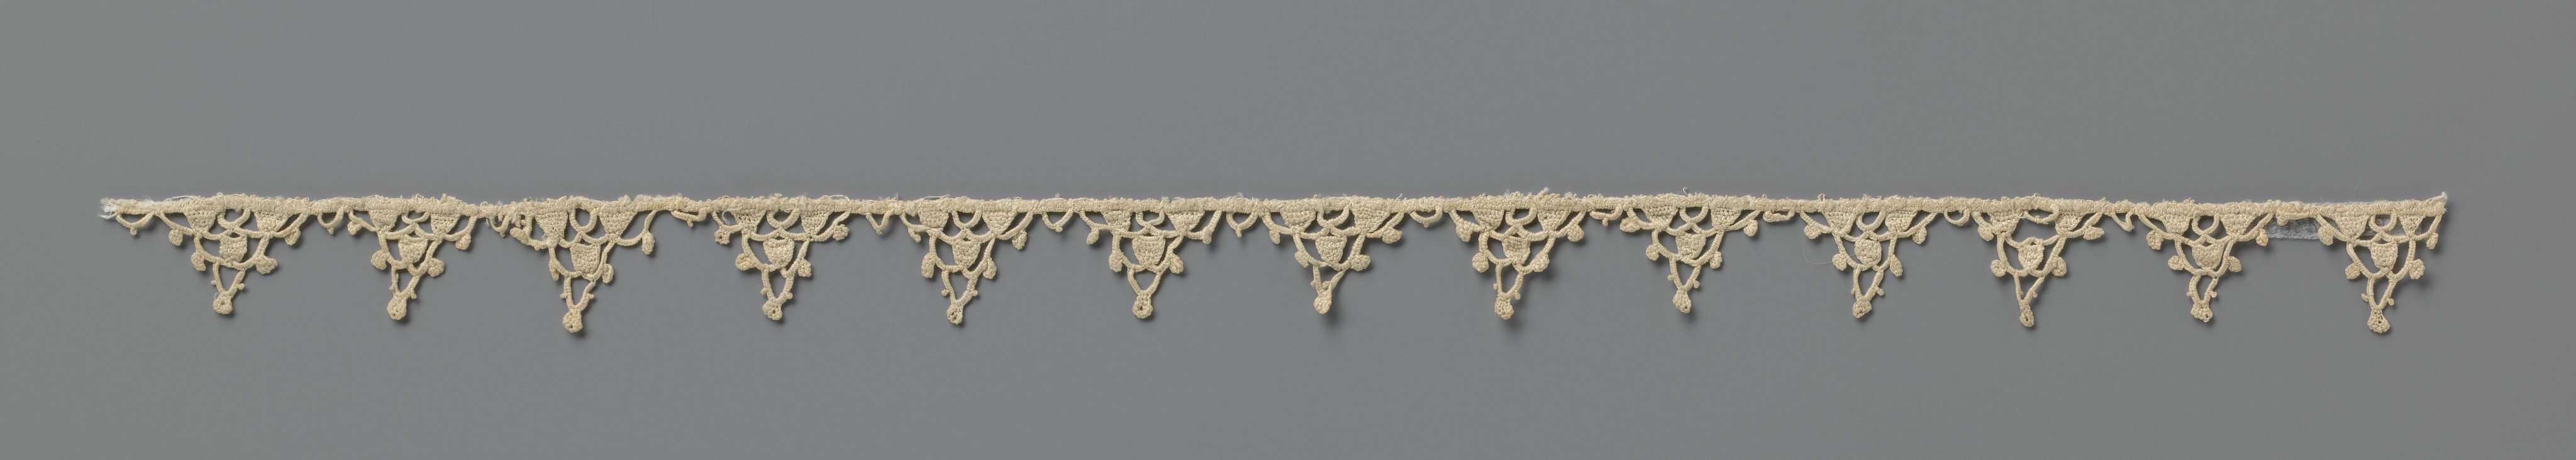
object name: strip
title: Strook naaldkant met driehoekige schulpjes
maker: Anonymous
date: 1600-1610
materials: linen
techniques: needle lace, punto in aria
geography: italy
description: De strook behoort tot een verzameling van achtentwintig stukken kant. De verzameling is bedoeld als studiemateriaal. De stukken zijn genummerd van BK-NM-14360-A t/m Z. Let op: bij -A en -C komen A-1, A-2, C-1 en C-2 voor.